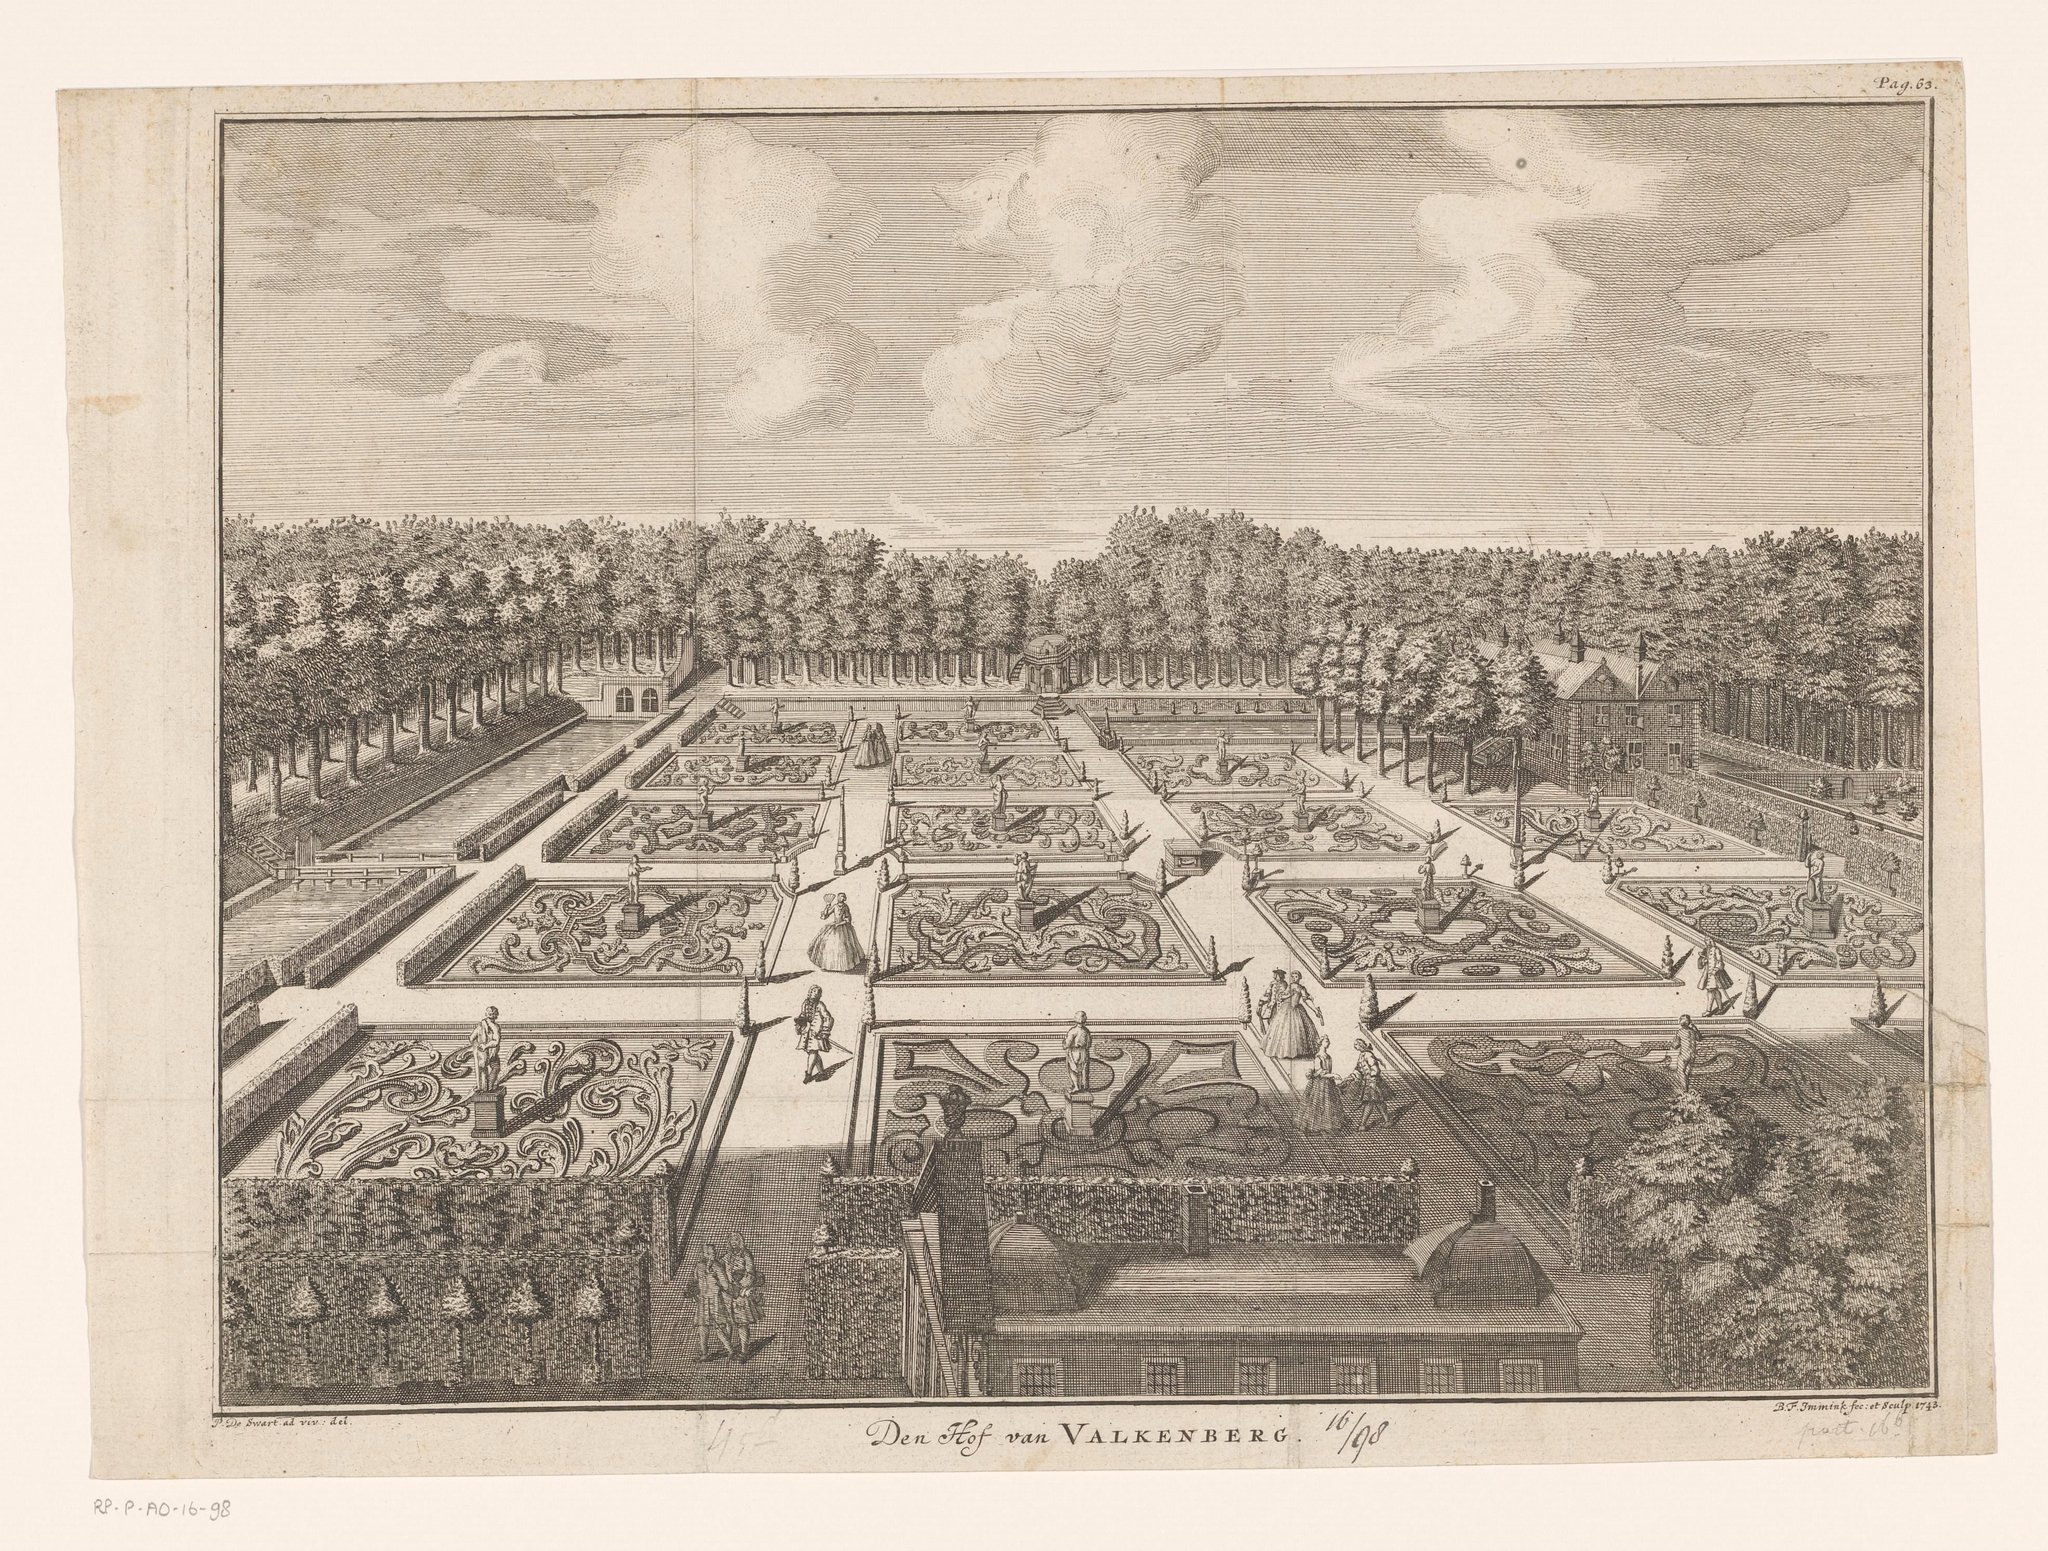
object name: book illustration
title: Den Hof van Valkenberg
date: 1743-1744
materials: paper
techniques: engraving, etching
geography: the hague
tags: french or architectonic garden; formal garden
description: Prent ook gebruikt in: Goor, Thomas Ernst van. Beschryving der stadt en lande van Breda: behelzende de oudheid van het graaffschap Stryen (…). Den Haag: Jacobus van den Kieboom, 1744, p. 63.